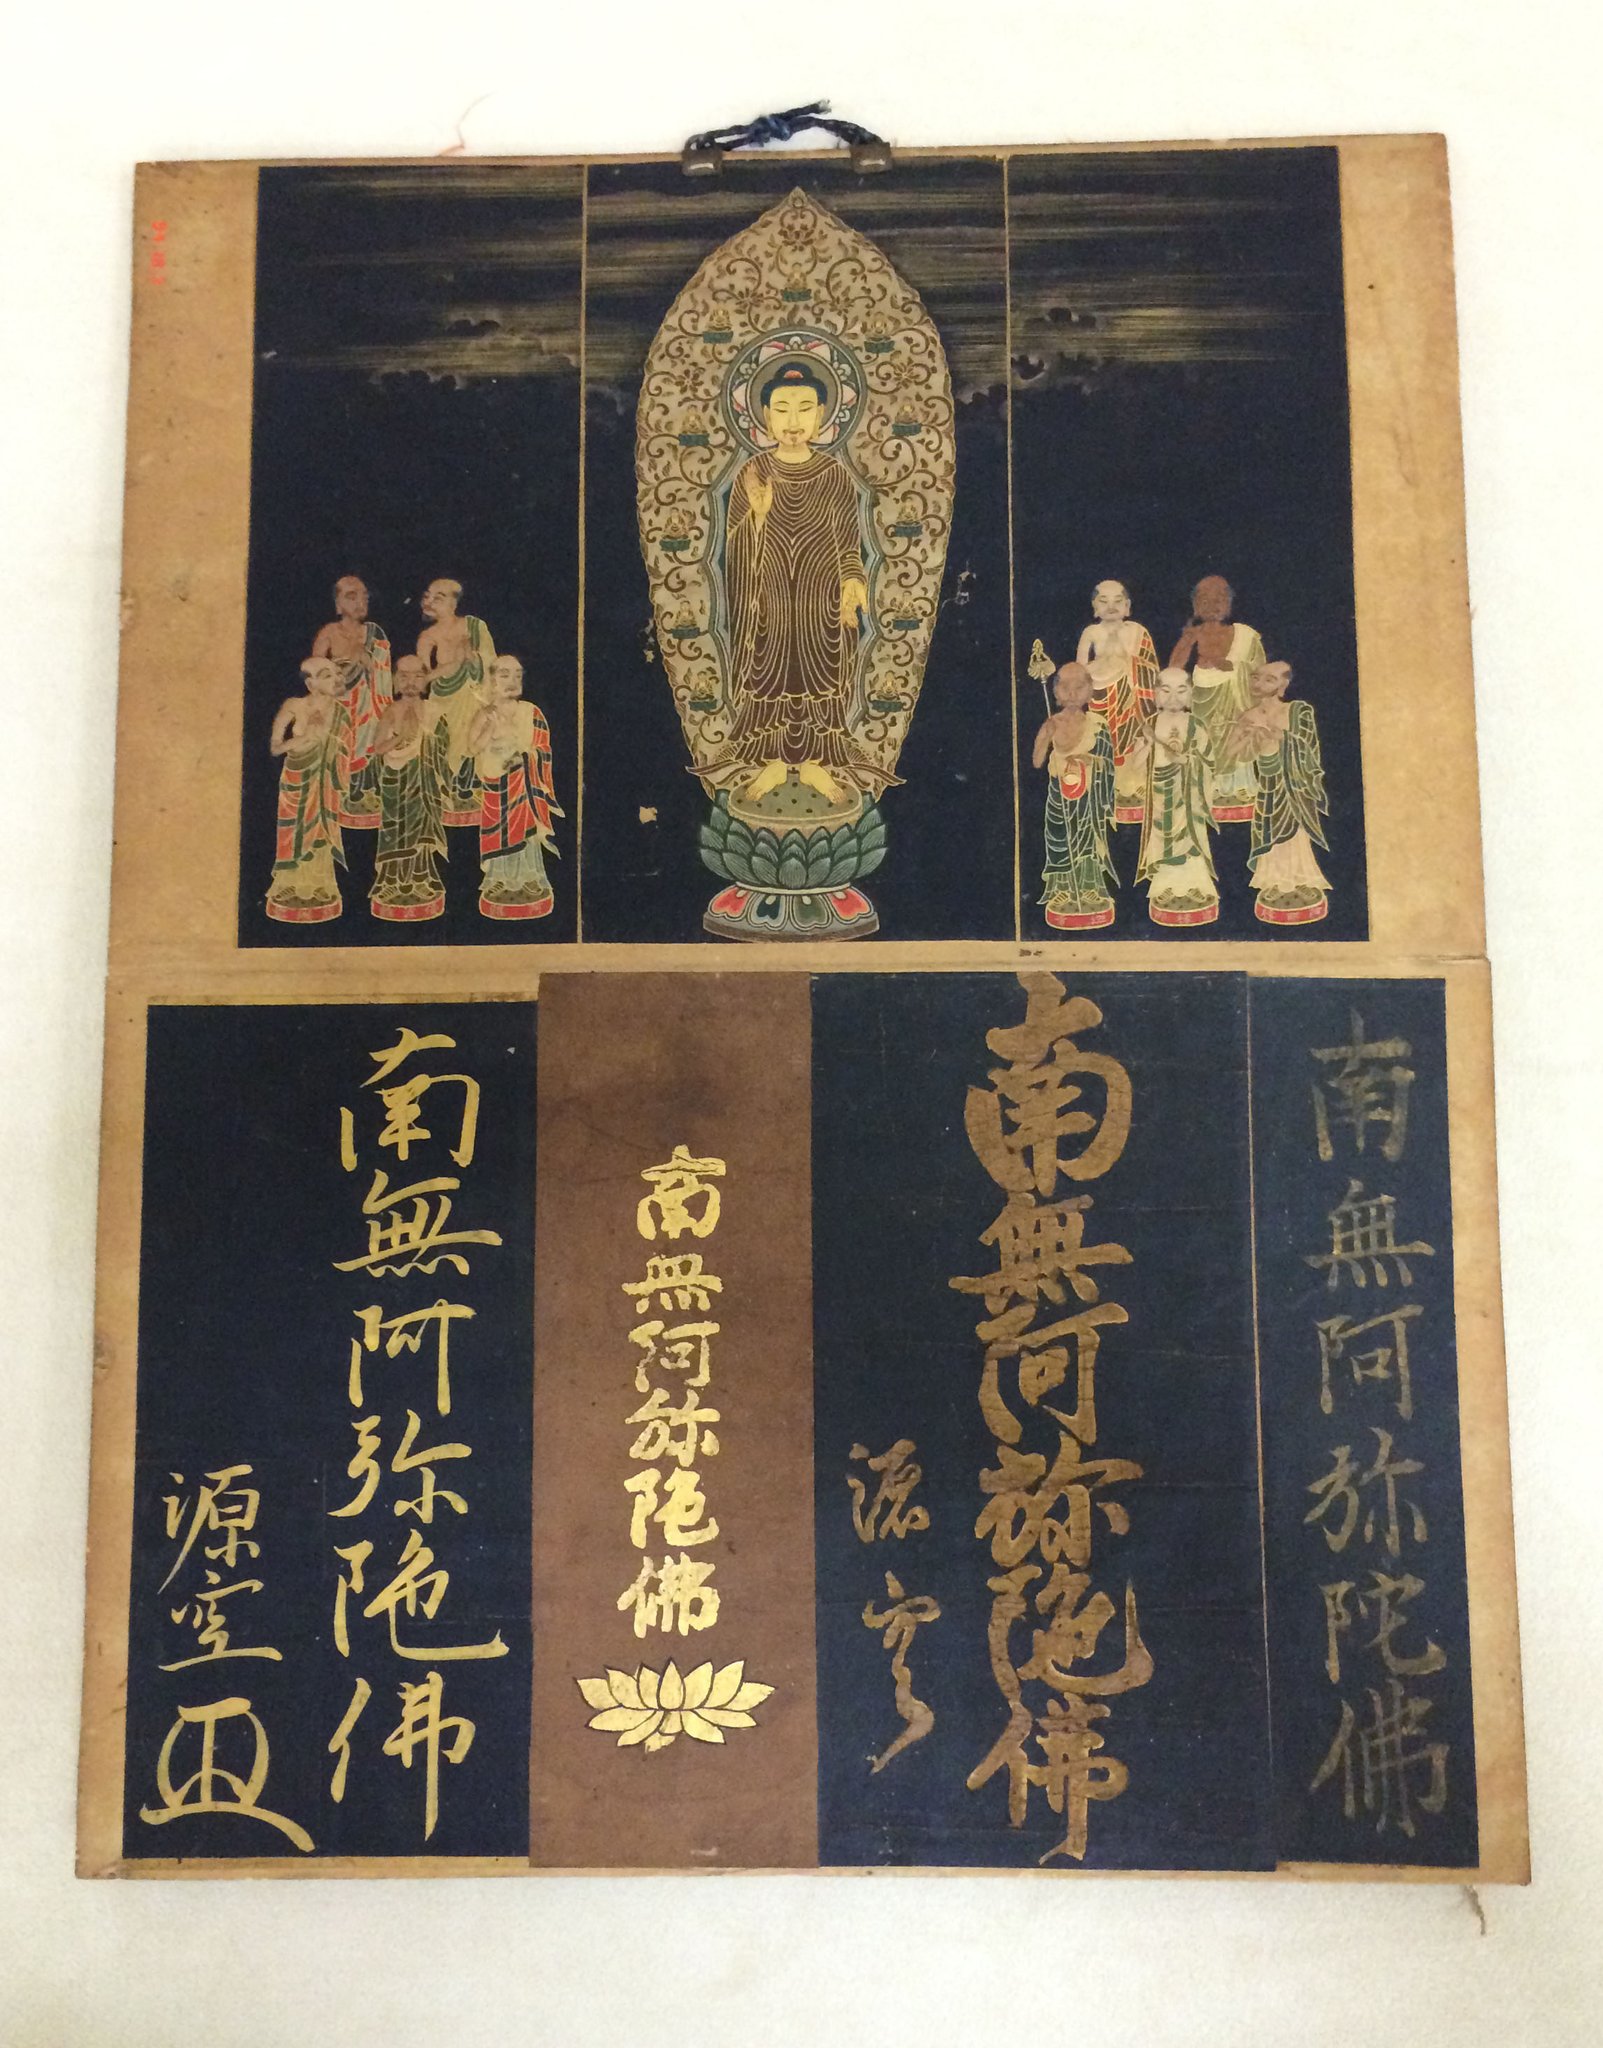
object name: book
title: Pilgrim's Visiting Album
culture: japanese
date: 1701-1800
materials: gilt, gold, ink, metal thread, paper, silk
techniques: calligraphy, embroidery, painting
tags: buddhism,buddha,monks